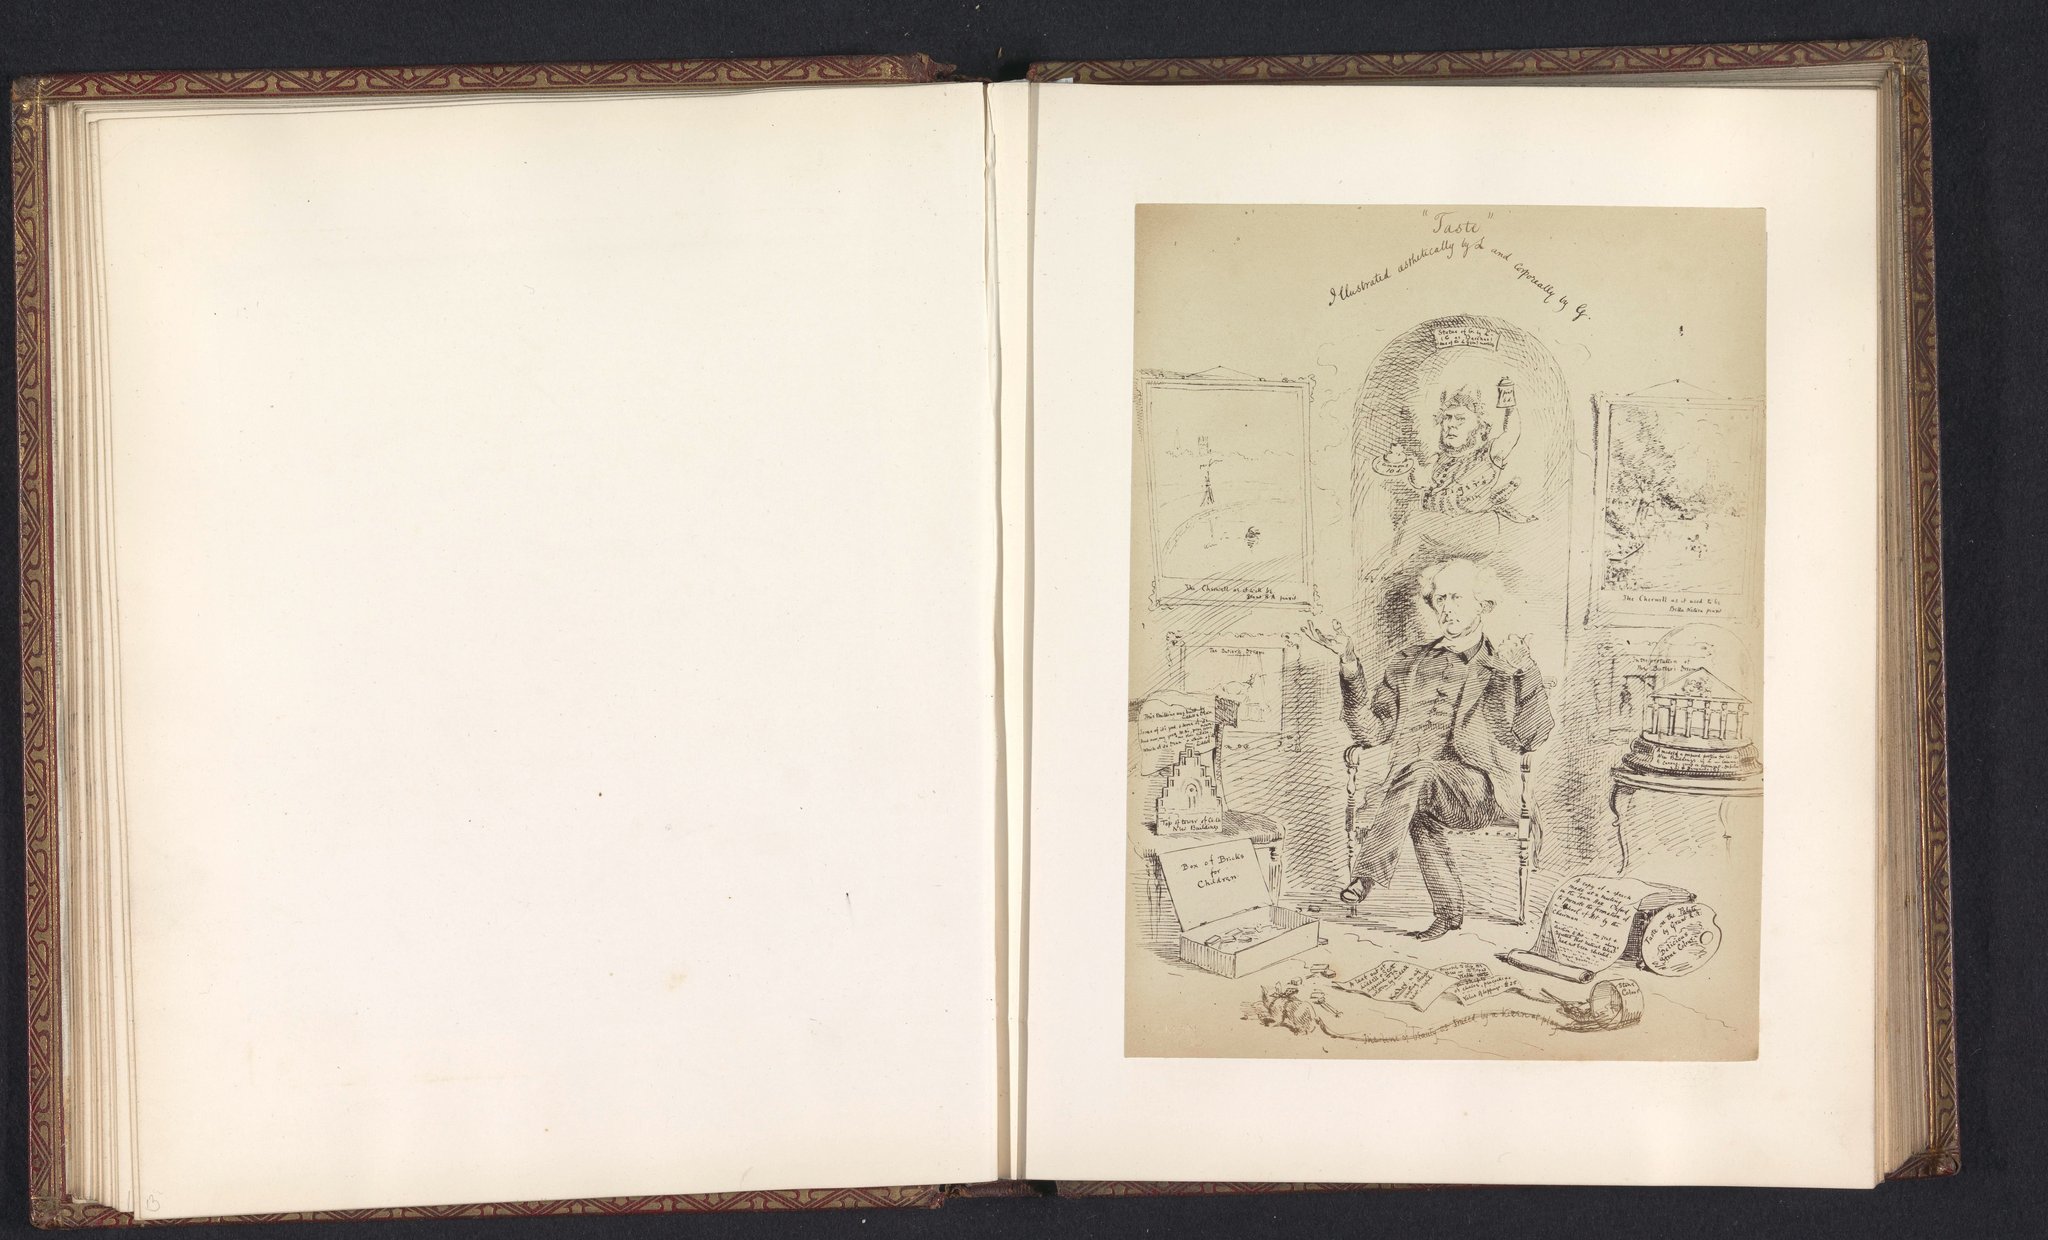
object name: reproduction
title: Fotoreproductie van een tekening, voorstellende de decaan van Cherwell College als de Goede Smaak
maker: Anonymous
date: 1855-1866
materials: photographic support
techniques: albumen print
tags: caricatures (human types), refinement, taste, student life